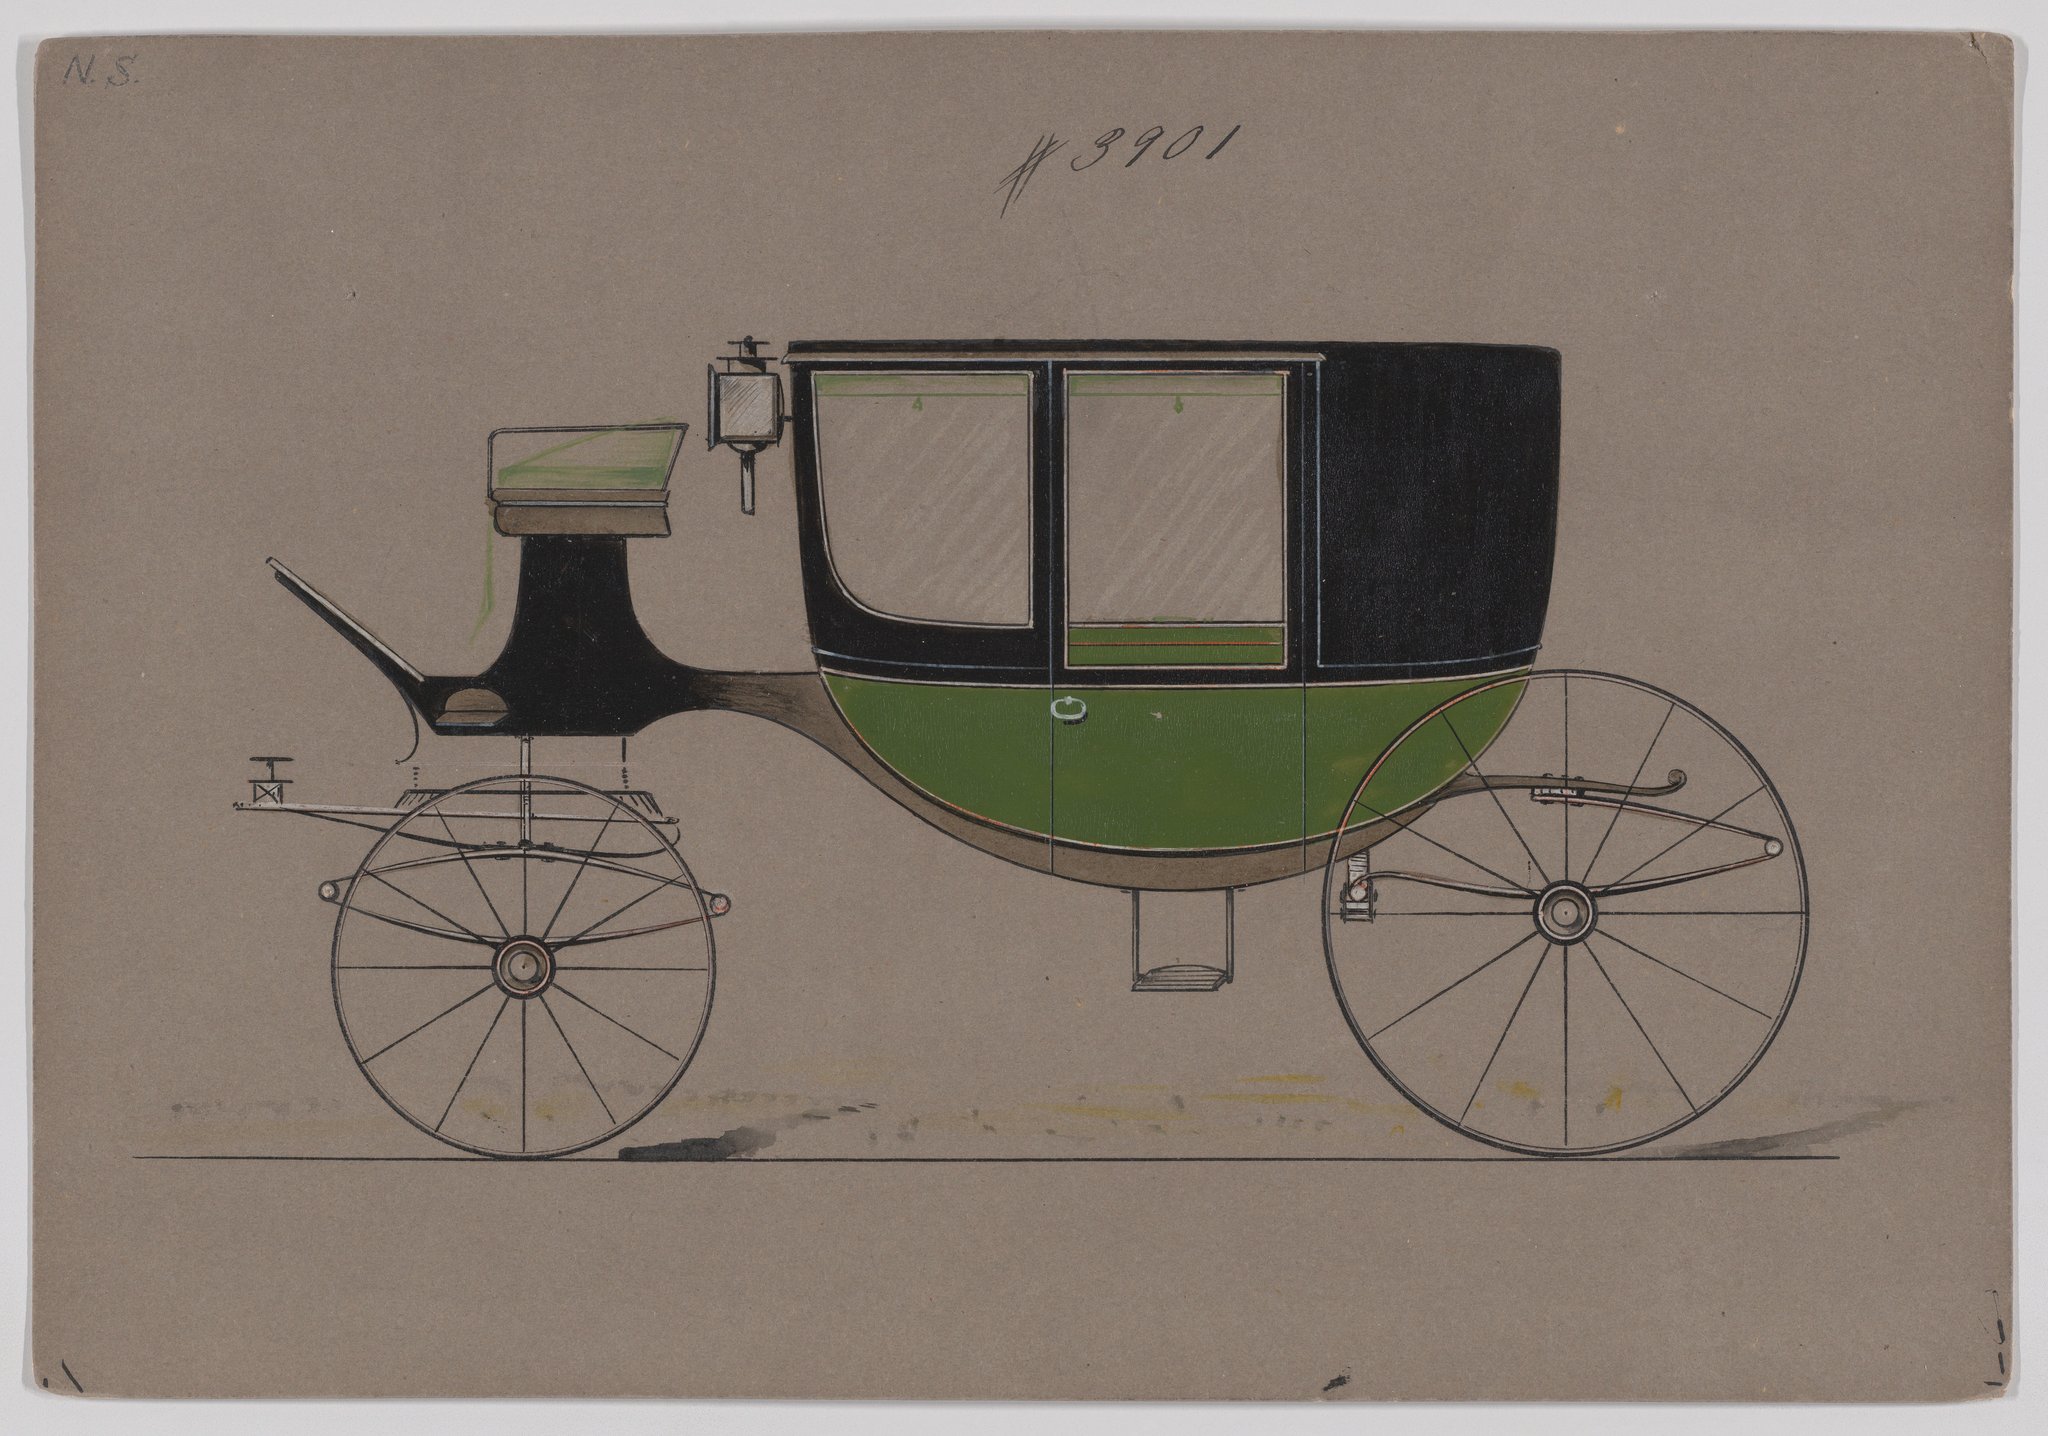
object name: drawing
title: Coach #3901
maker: brewster & co.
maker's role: manufacturer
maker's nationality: american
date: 1884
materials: gouache, gum arabic, ink, watercolor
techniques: pen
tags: carriages